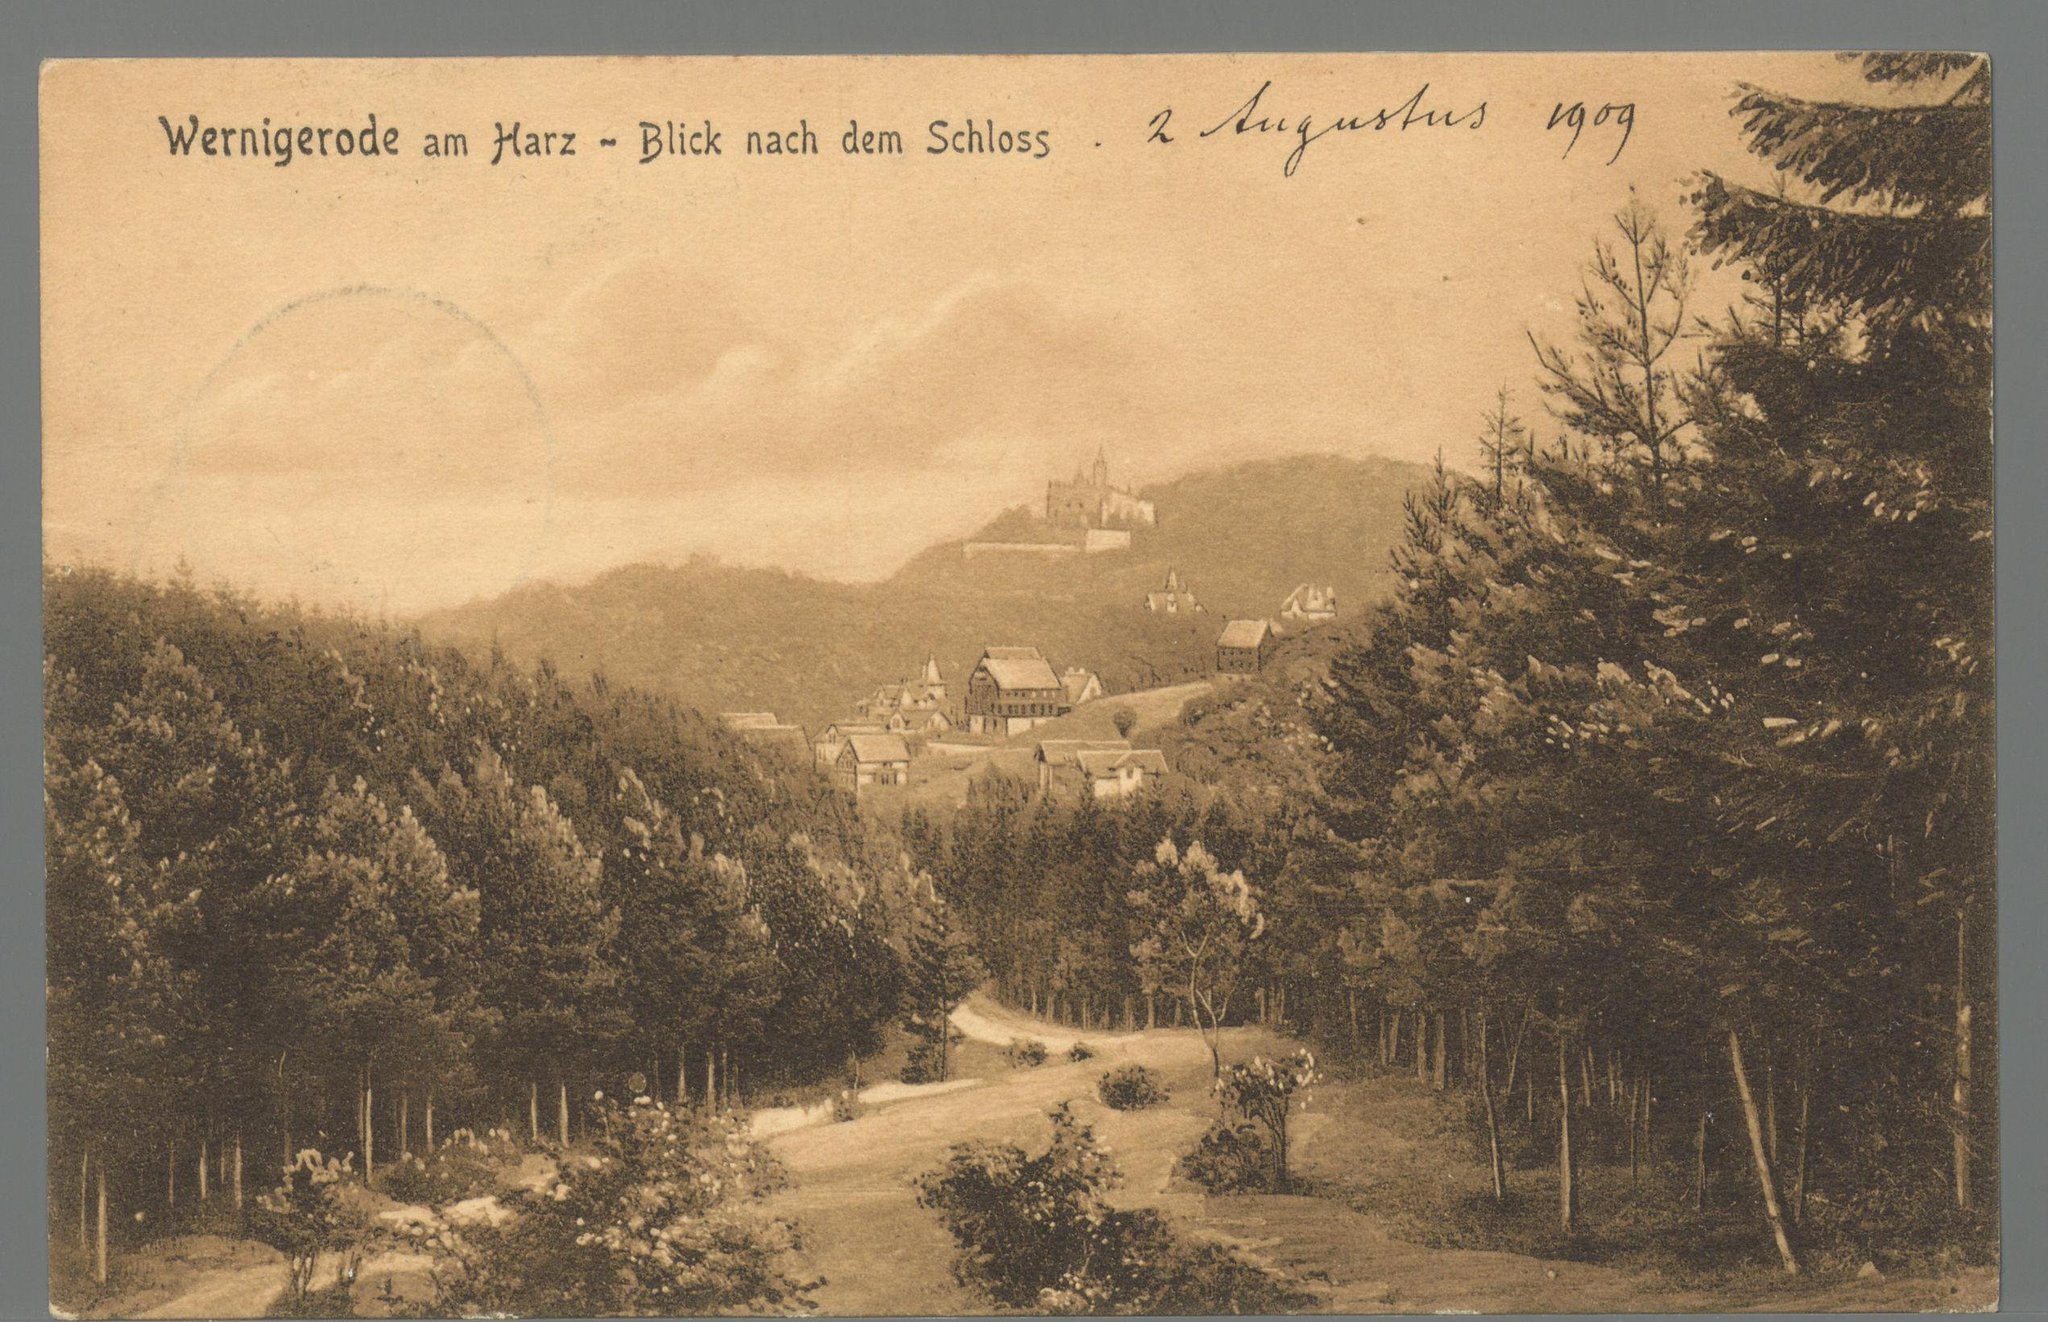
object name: photomechanical print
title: Wernigerode am Harz - Blick nach dem Schloss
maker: Anonymous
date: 1908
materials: cardboard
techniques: photograph, writing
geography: wernigerode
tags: castle, mountains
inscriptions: postage stamp